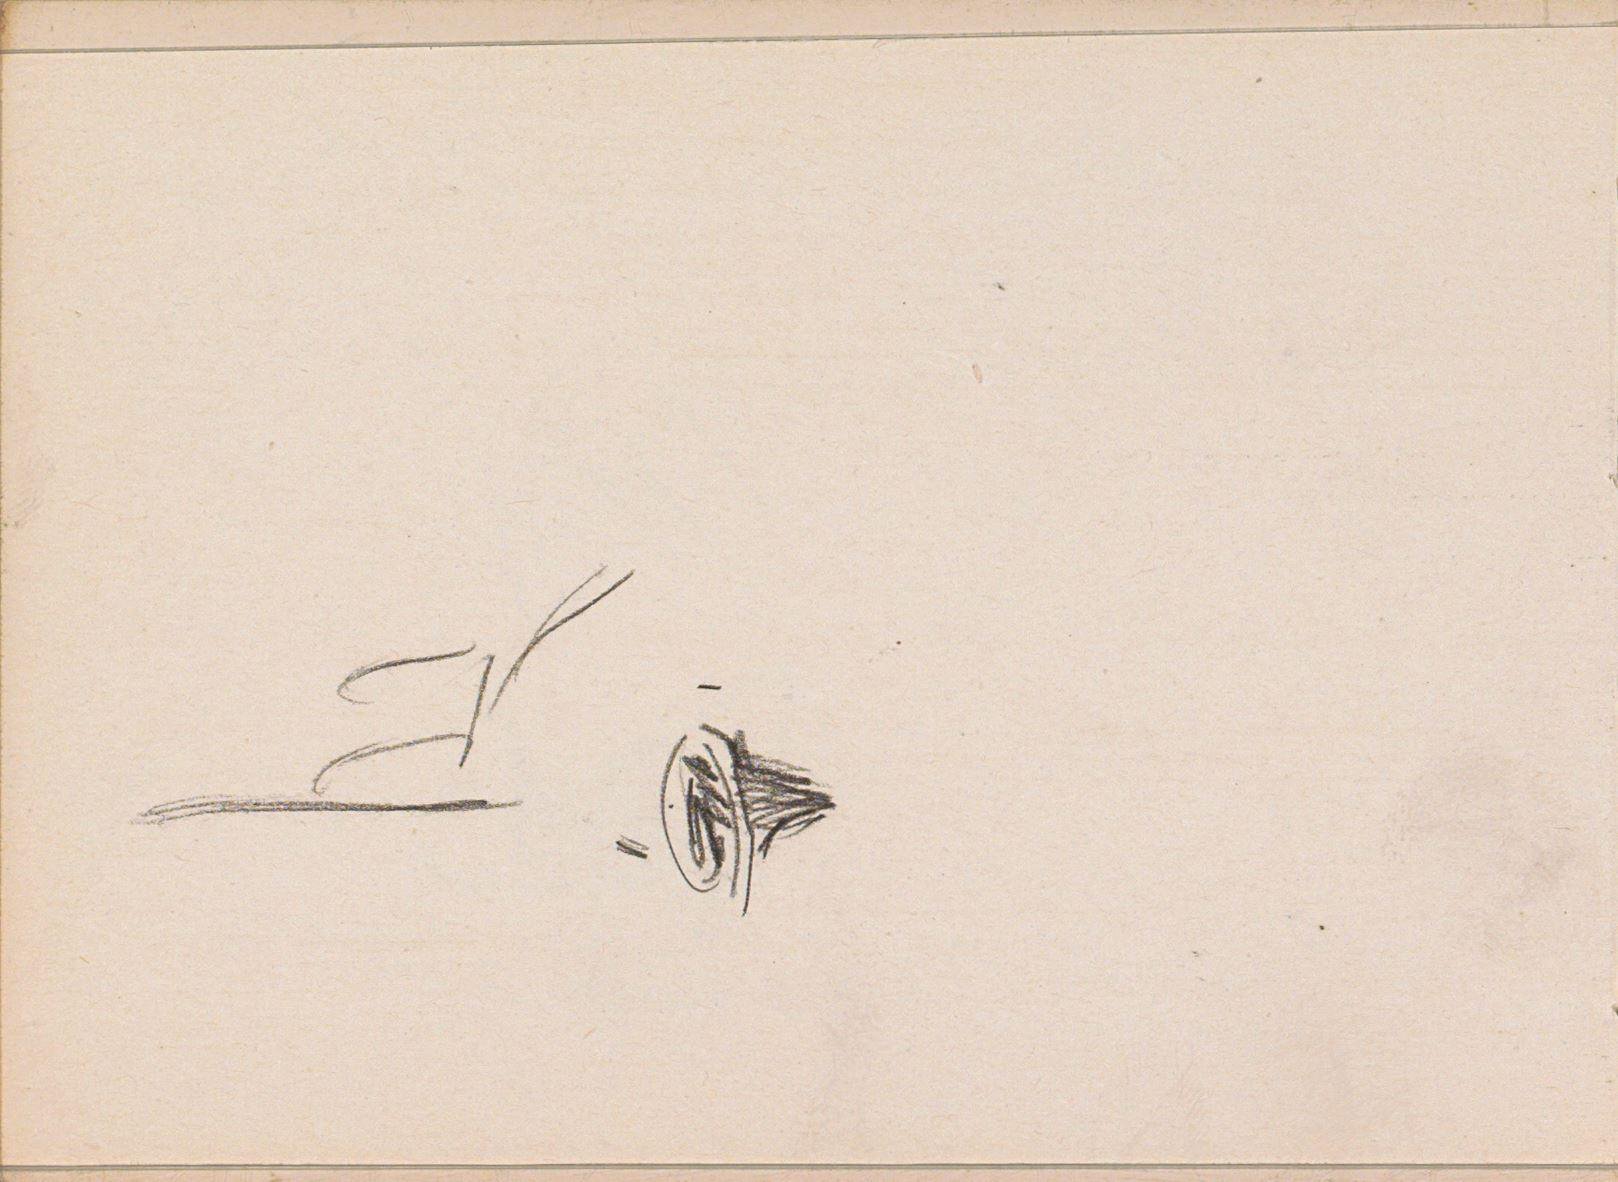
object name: sketchbook leaf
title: Onderdeel van een koperen blaasinstrument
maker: isaac israels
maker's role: draughtsman, painter, print maker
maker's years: 1865-1934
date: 1875-1934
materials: chalk, paper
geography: paris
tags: horn, trumpet, cornet, trombone, tuba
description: Pagina 25 uit schetsboek XLV met 85 pagina's.